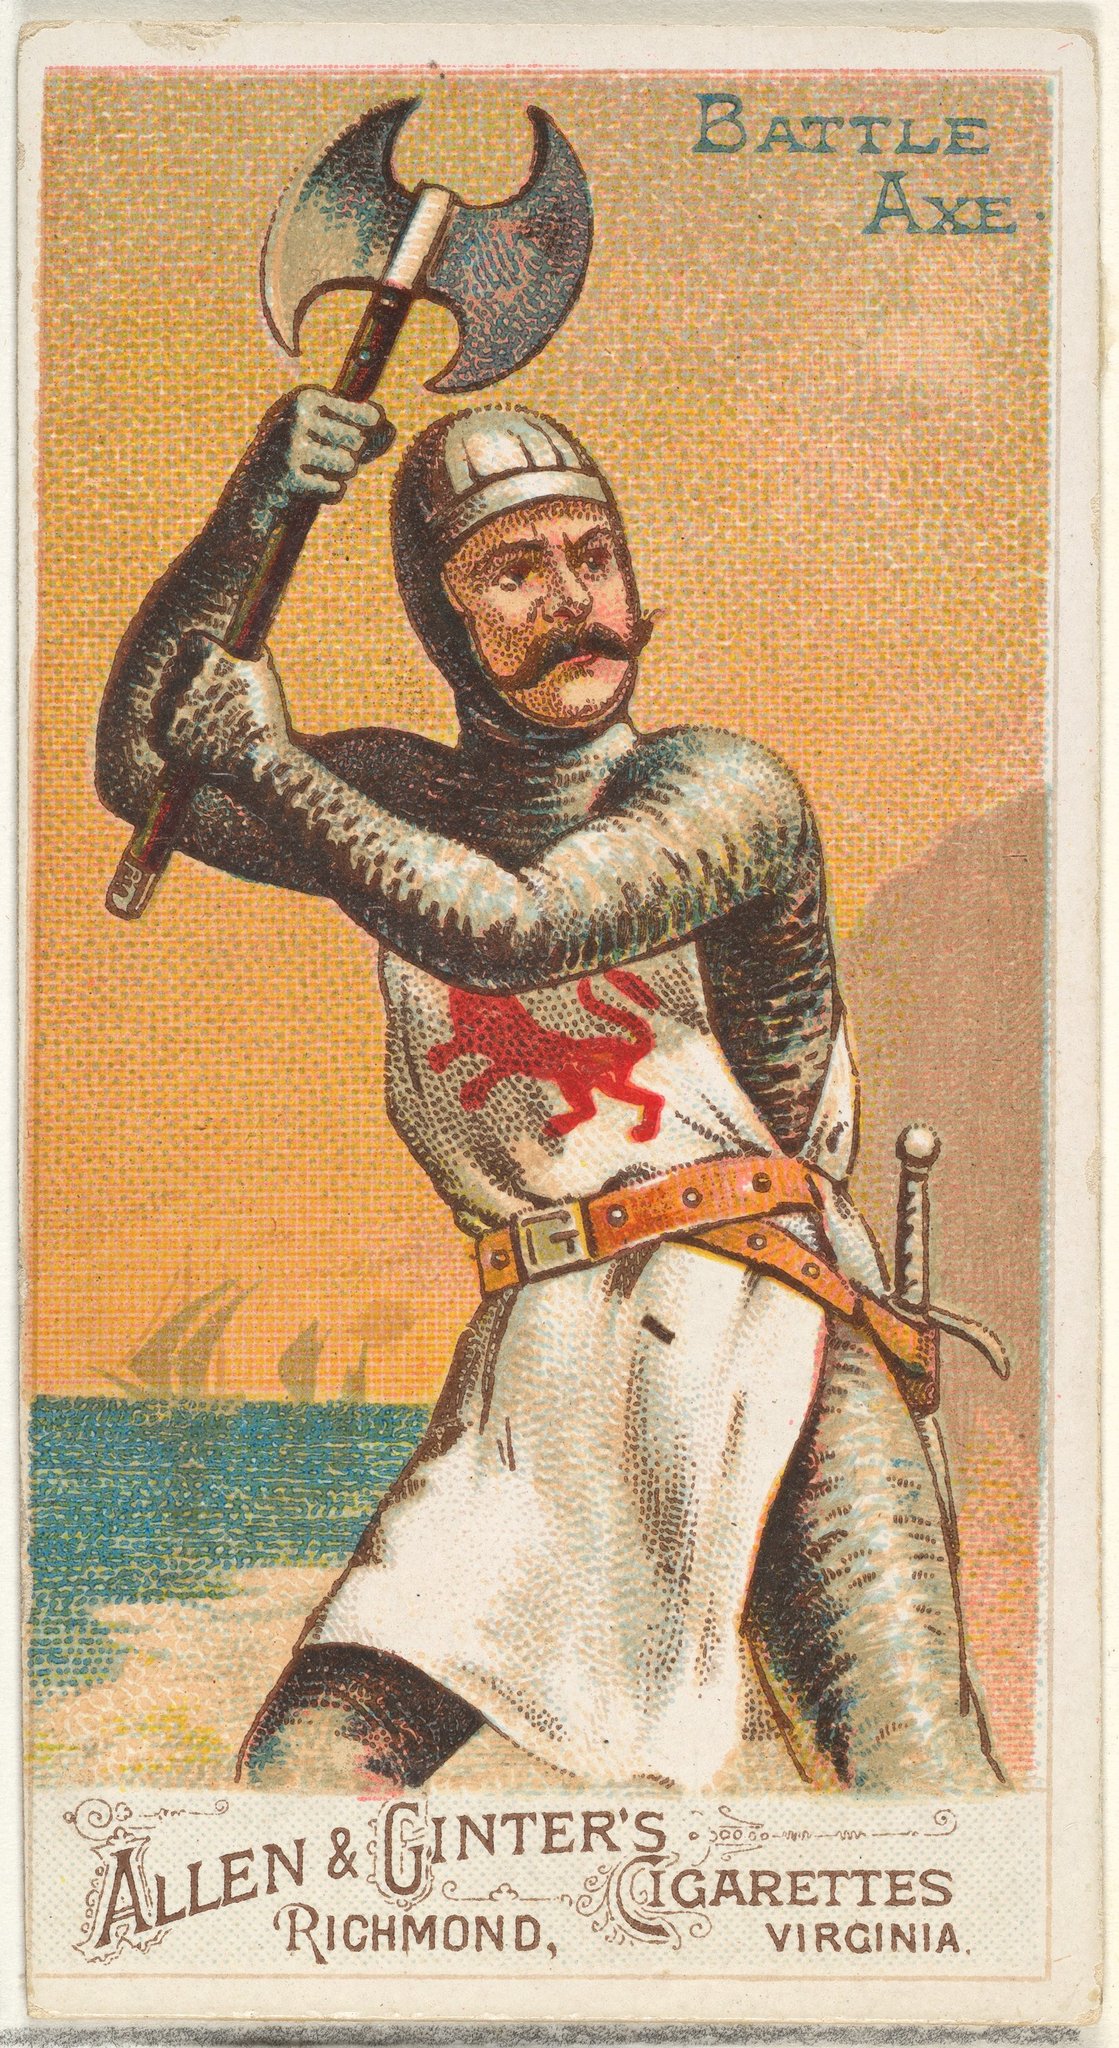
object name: print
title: Battle Axe, from the Arms of All Nations series (N3) for Allen & Ginter Cigarettes Brands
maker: allen & ginter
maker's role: publisher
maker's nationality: american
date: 1887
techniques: color lithograph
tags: soldiers,axes